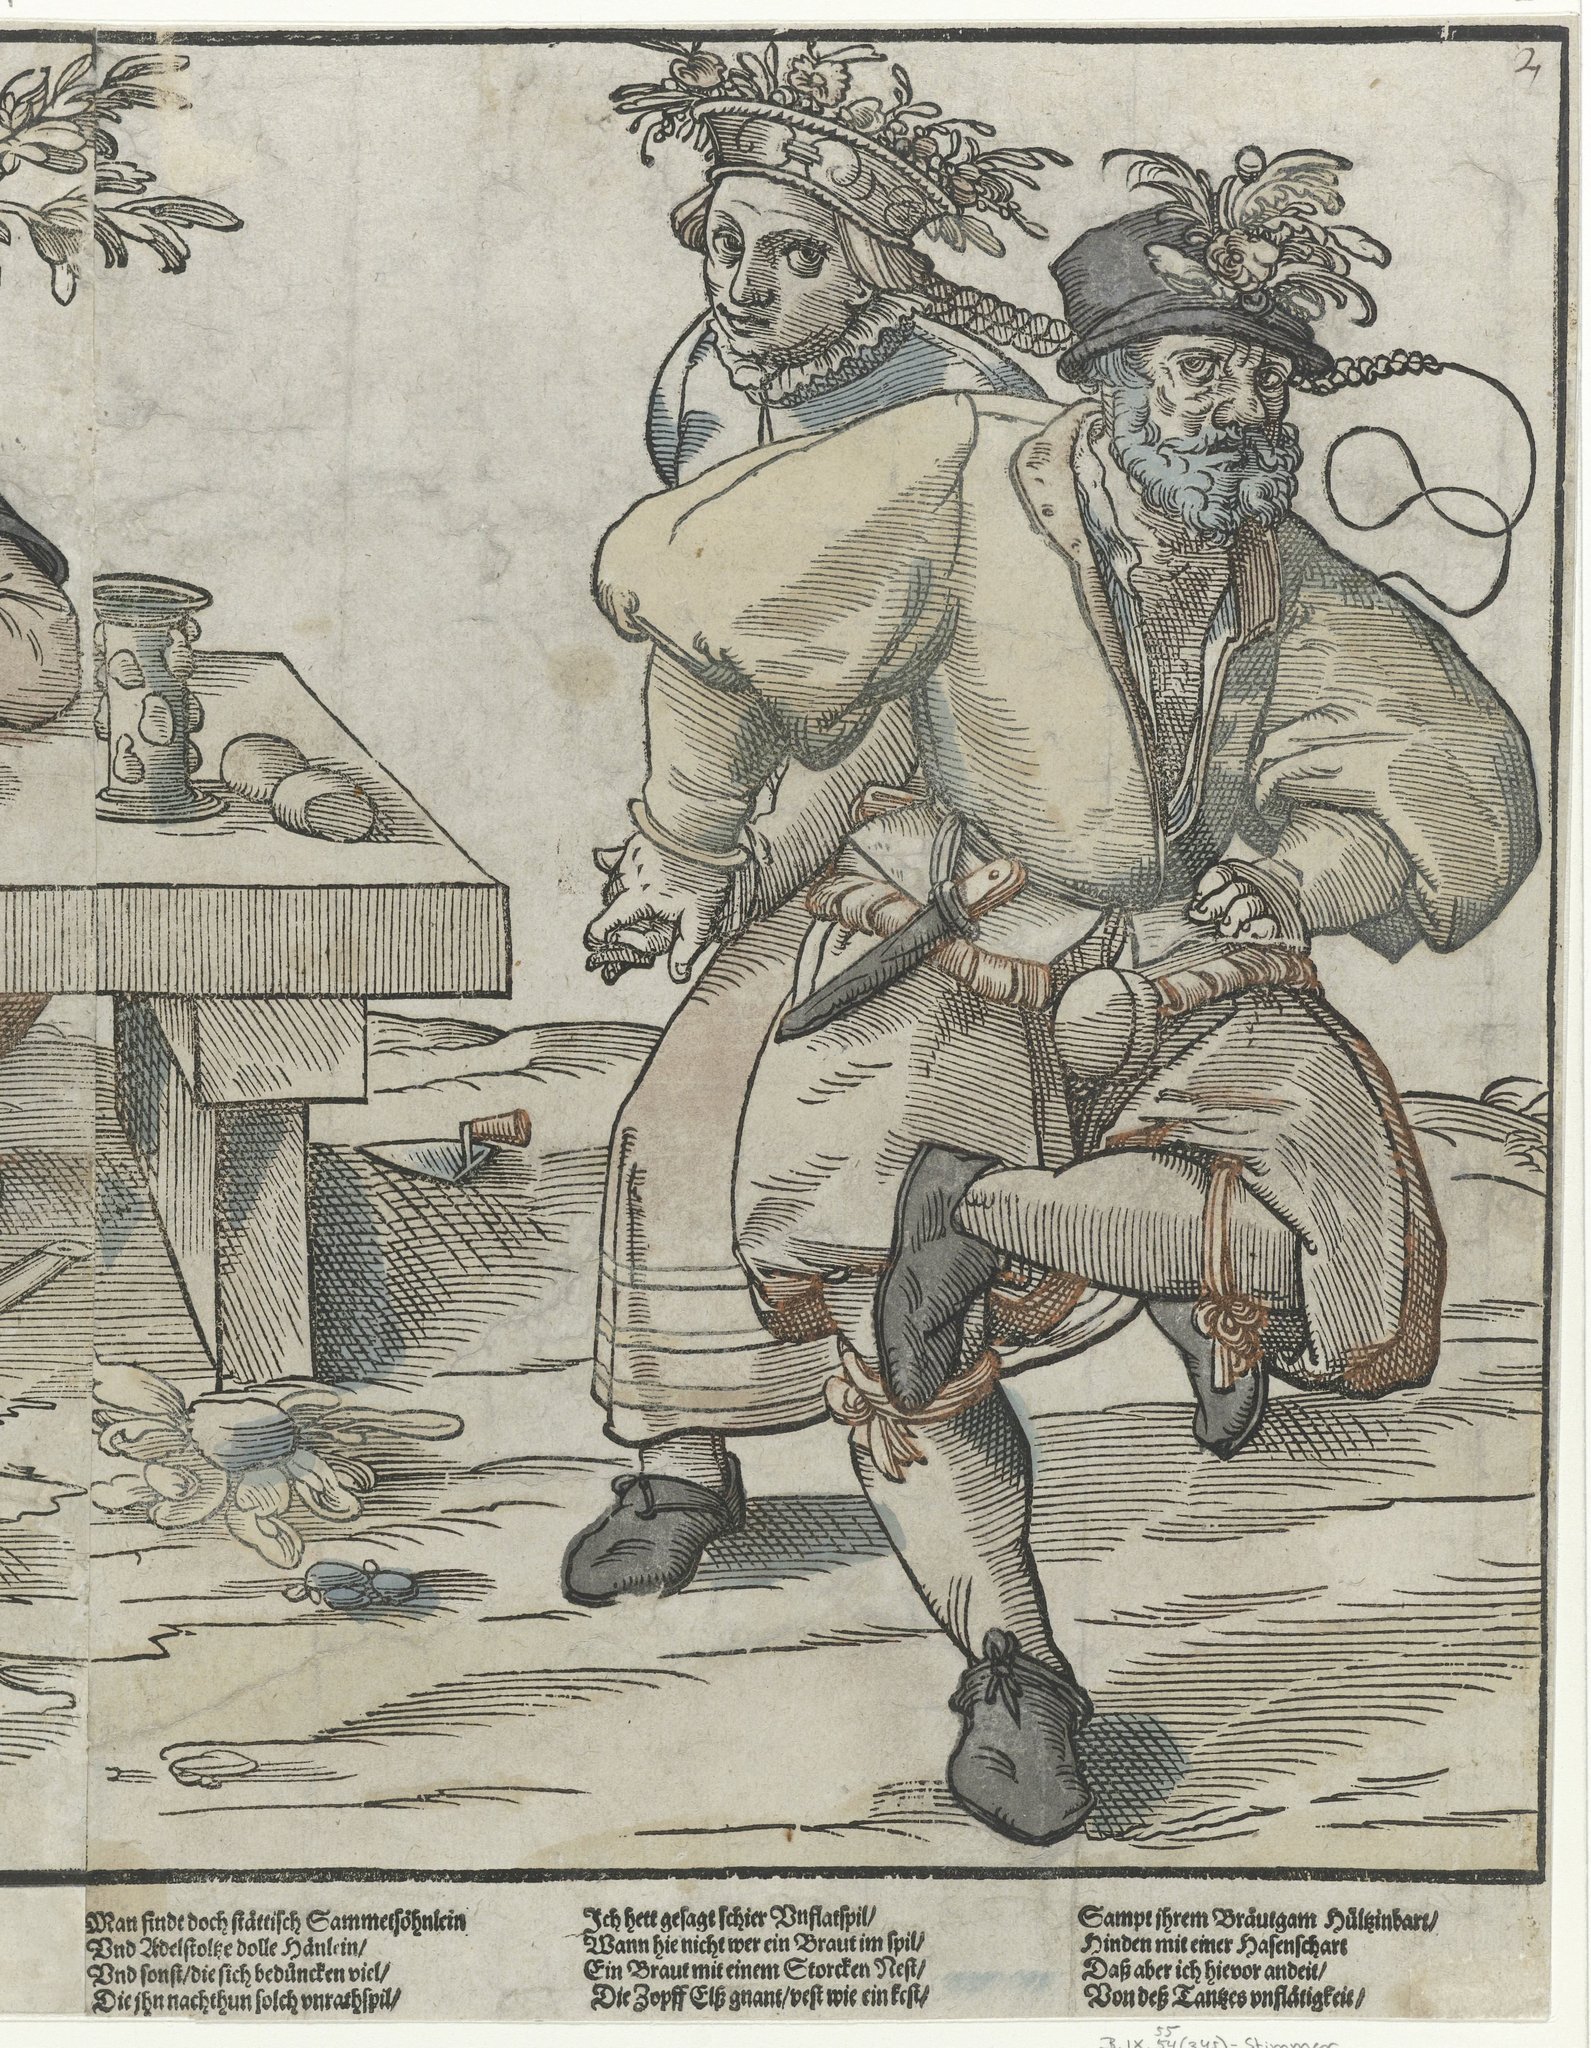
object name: print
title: Dorpsbruiloftsfeest met dansende paren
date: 1590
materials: paper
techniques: hand coloring, letterpress printing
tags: bagpipe, musette